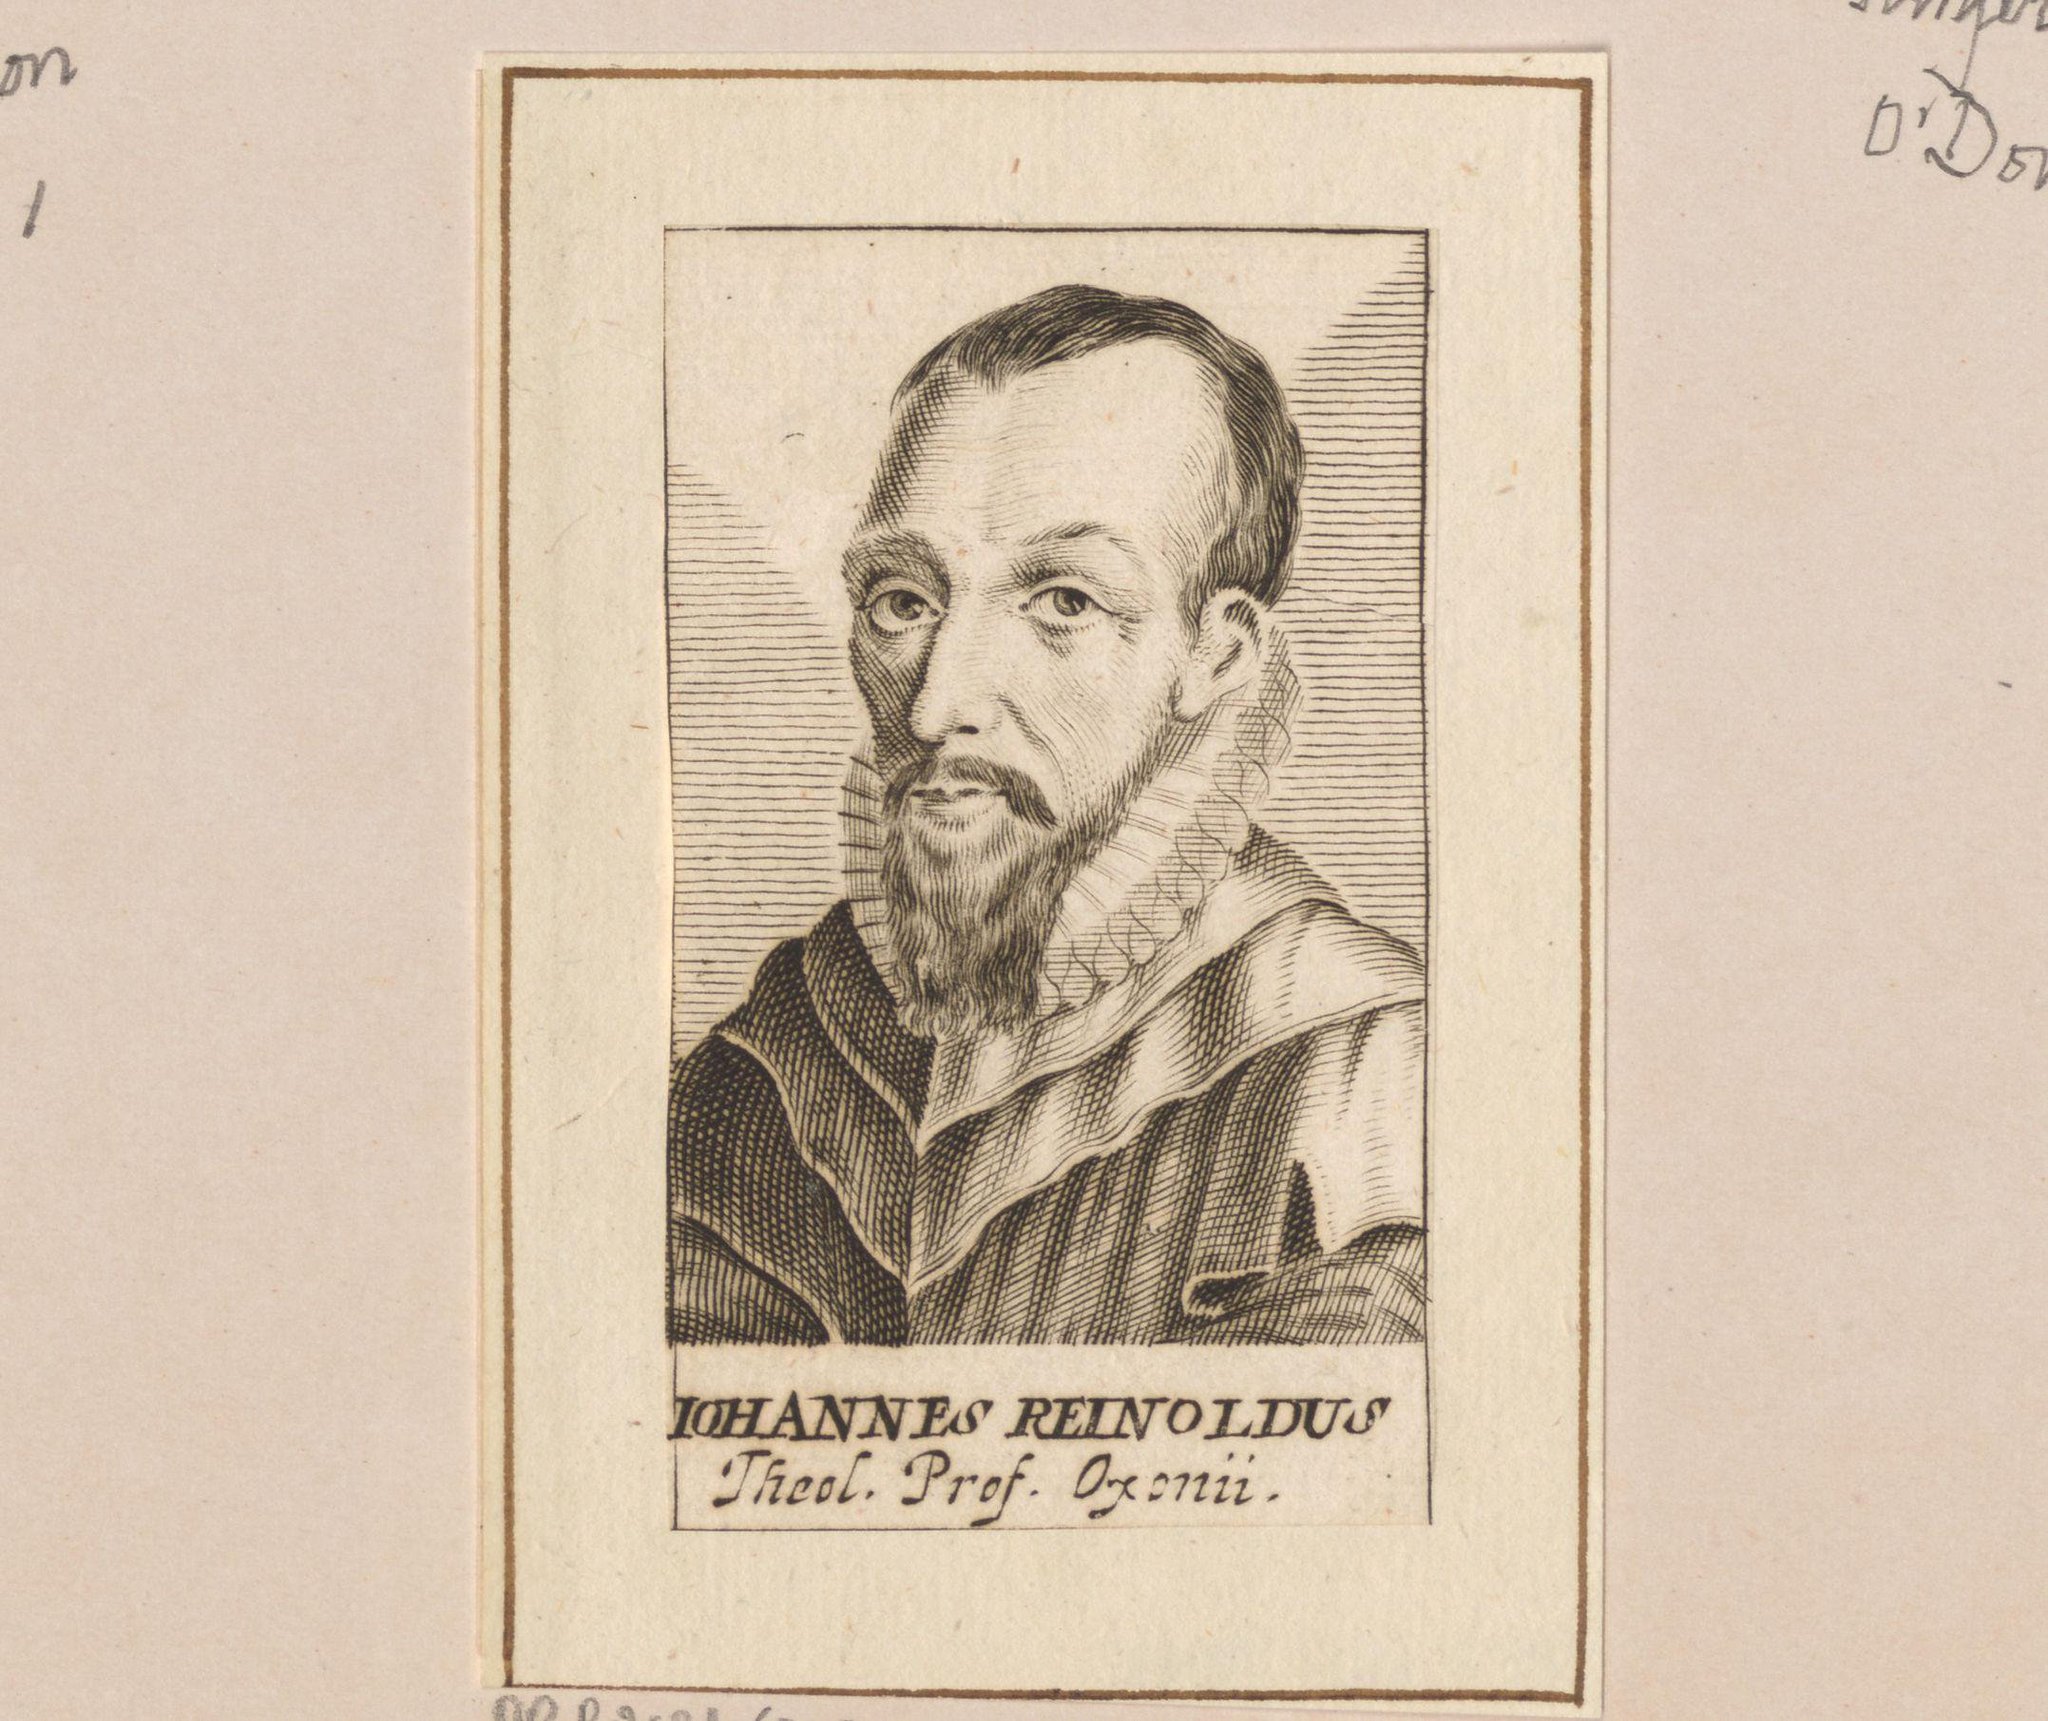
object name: print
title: Portret van John Rainolds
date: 1688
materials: paper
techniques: engraving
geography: nuremberg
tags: clergyman, historical persons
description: Prent mogelijk uit: Freher, Paul. Theatrum virorum eruditione clarorum. Neurenberg: Johann Hoffmann, 1688.